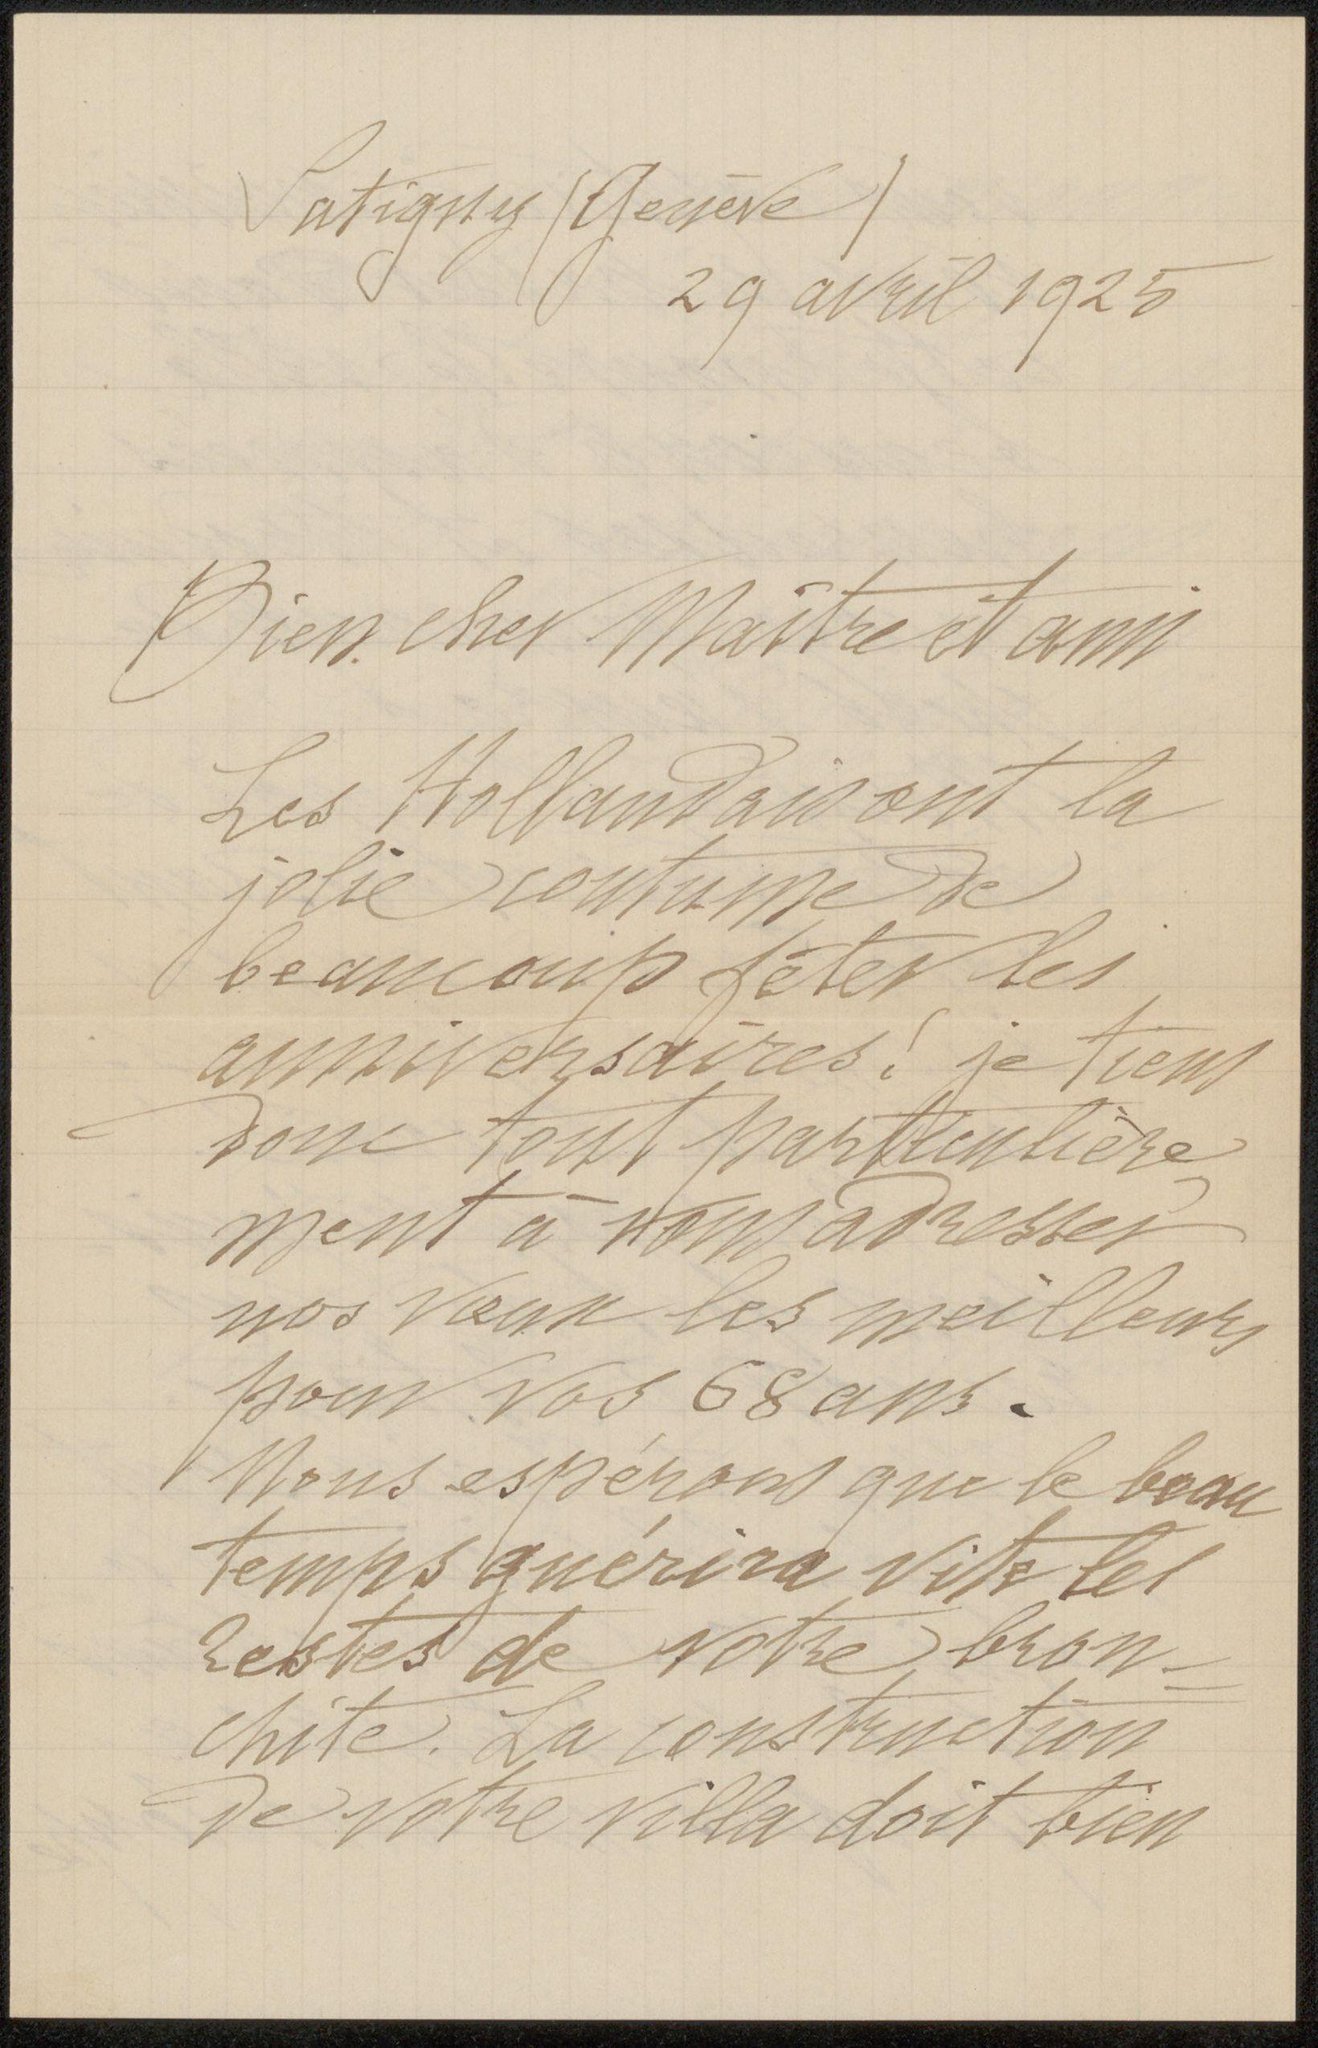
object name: letter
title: Brief aan Philip Zilcken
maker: alphonse stengelin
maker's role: painter, print maker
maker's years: 1852-1938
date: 1925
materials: ink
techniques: pen, writing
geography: satigny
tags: draughtsman, philip zilcken, diseases, printed matter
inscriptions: collector's mark: ‘RPK’